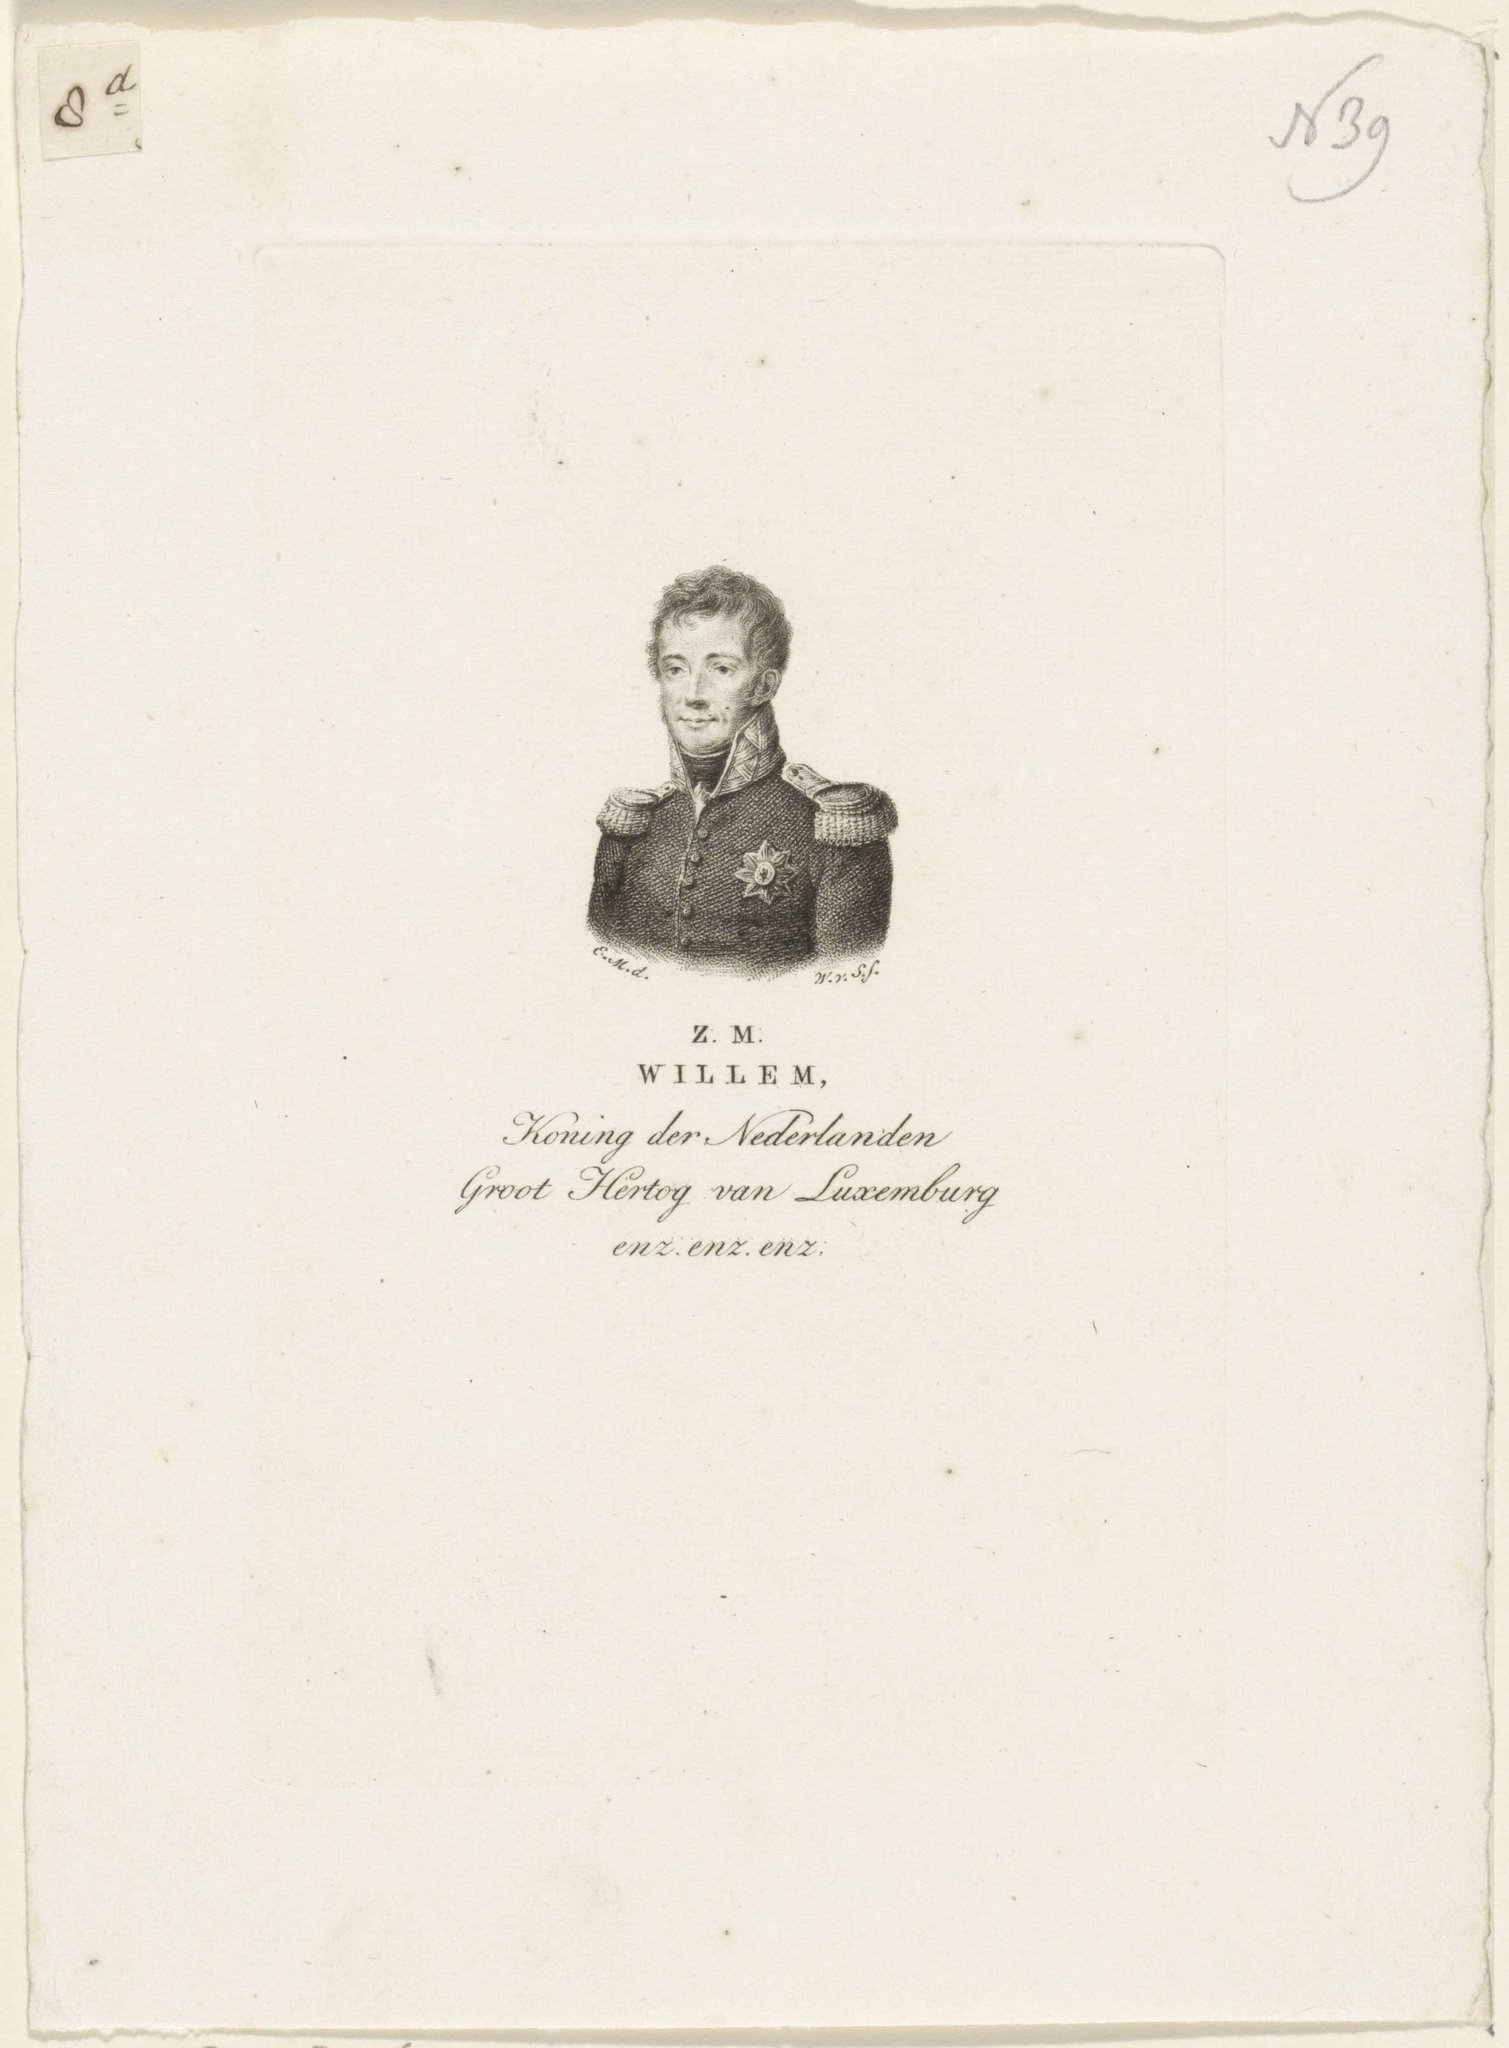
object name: print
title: Portret van Willem I Frederik, koning der Nederlanden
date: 1815-1851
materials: paper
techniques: engraving, etching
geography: netherlands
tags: the hague, berlin, william i of the netherlands, knighthood order (with name) - insignia of a knighthood order, e.g.: badge, chain (with name of order)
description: De hier vermelde titel verwijst naar de hoogst verkregen titel van de geportretteerde, niet per se naar de titel die de geportretteerde op deze voorstelling draagt.